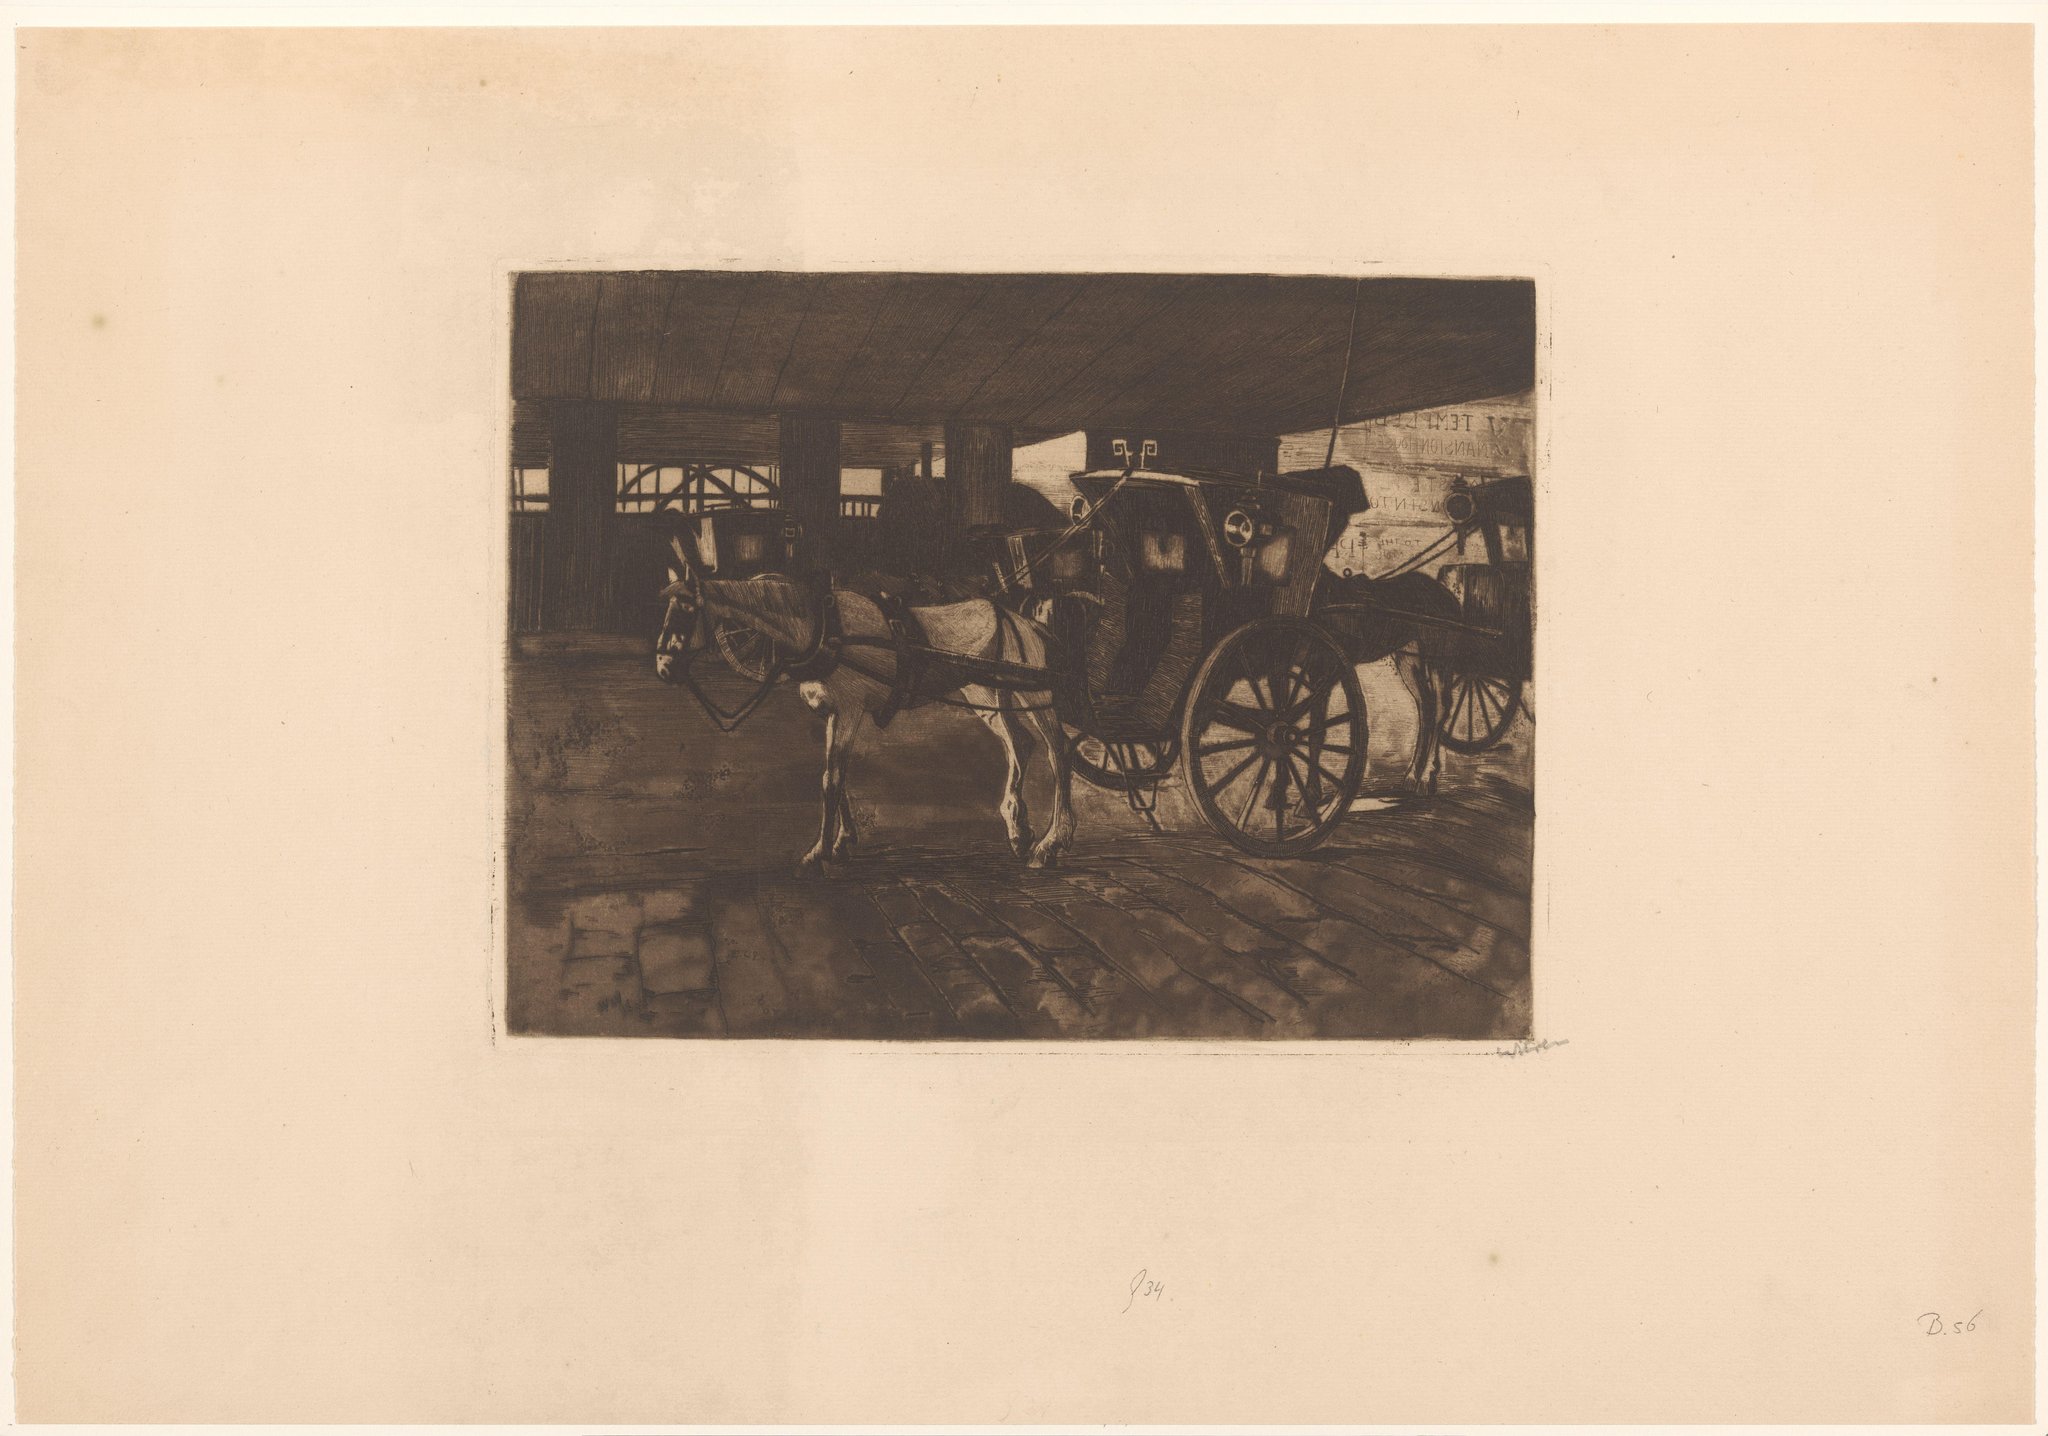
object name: print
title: Wachtende rijtuigen onder de Charing Cross Bridge in Londen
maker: willem witsen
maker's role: draughtsman, painter, print maker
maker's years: 1860-1923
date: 1890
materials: paper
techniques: aquatint, etching, intaglio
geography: london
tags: horse, bridge, passenger carriage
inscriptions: signature: ‘Witsen’, collector's mark: Lugt 2228, watermark